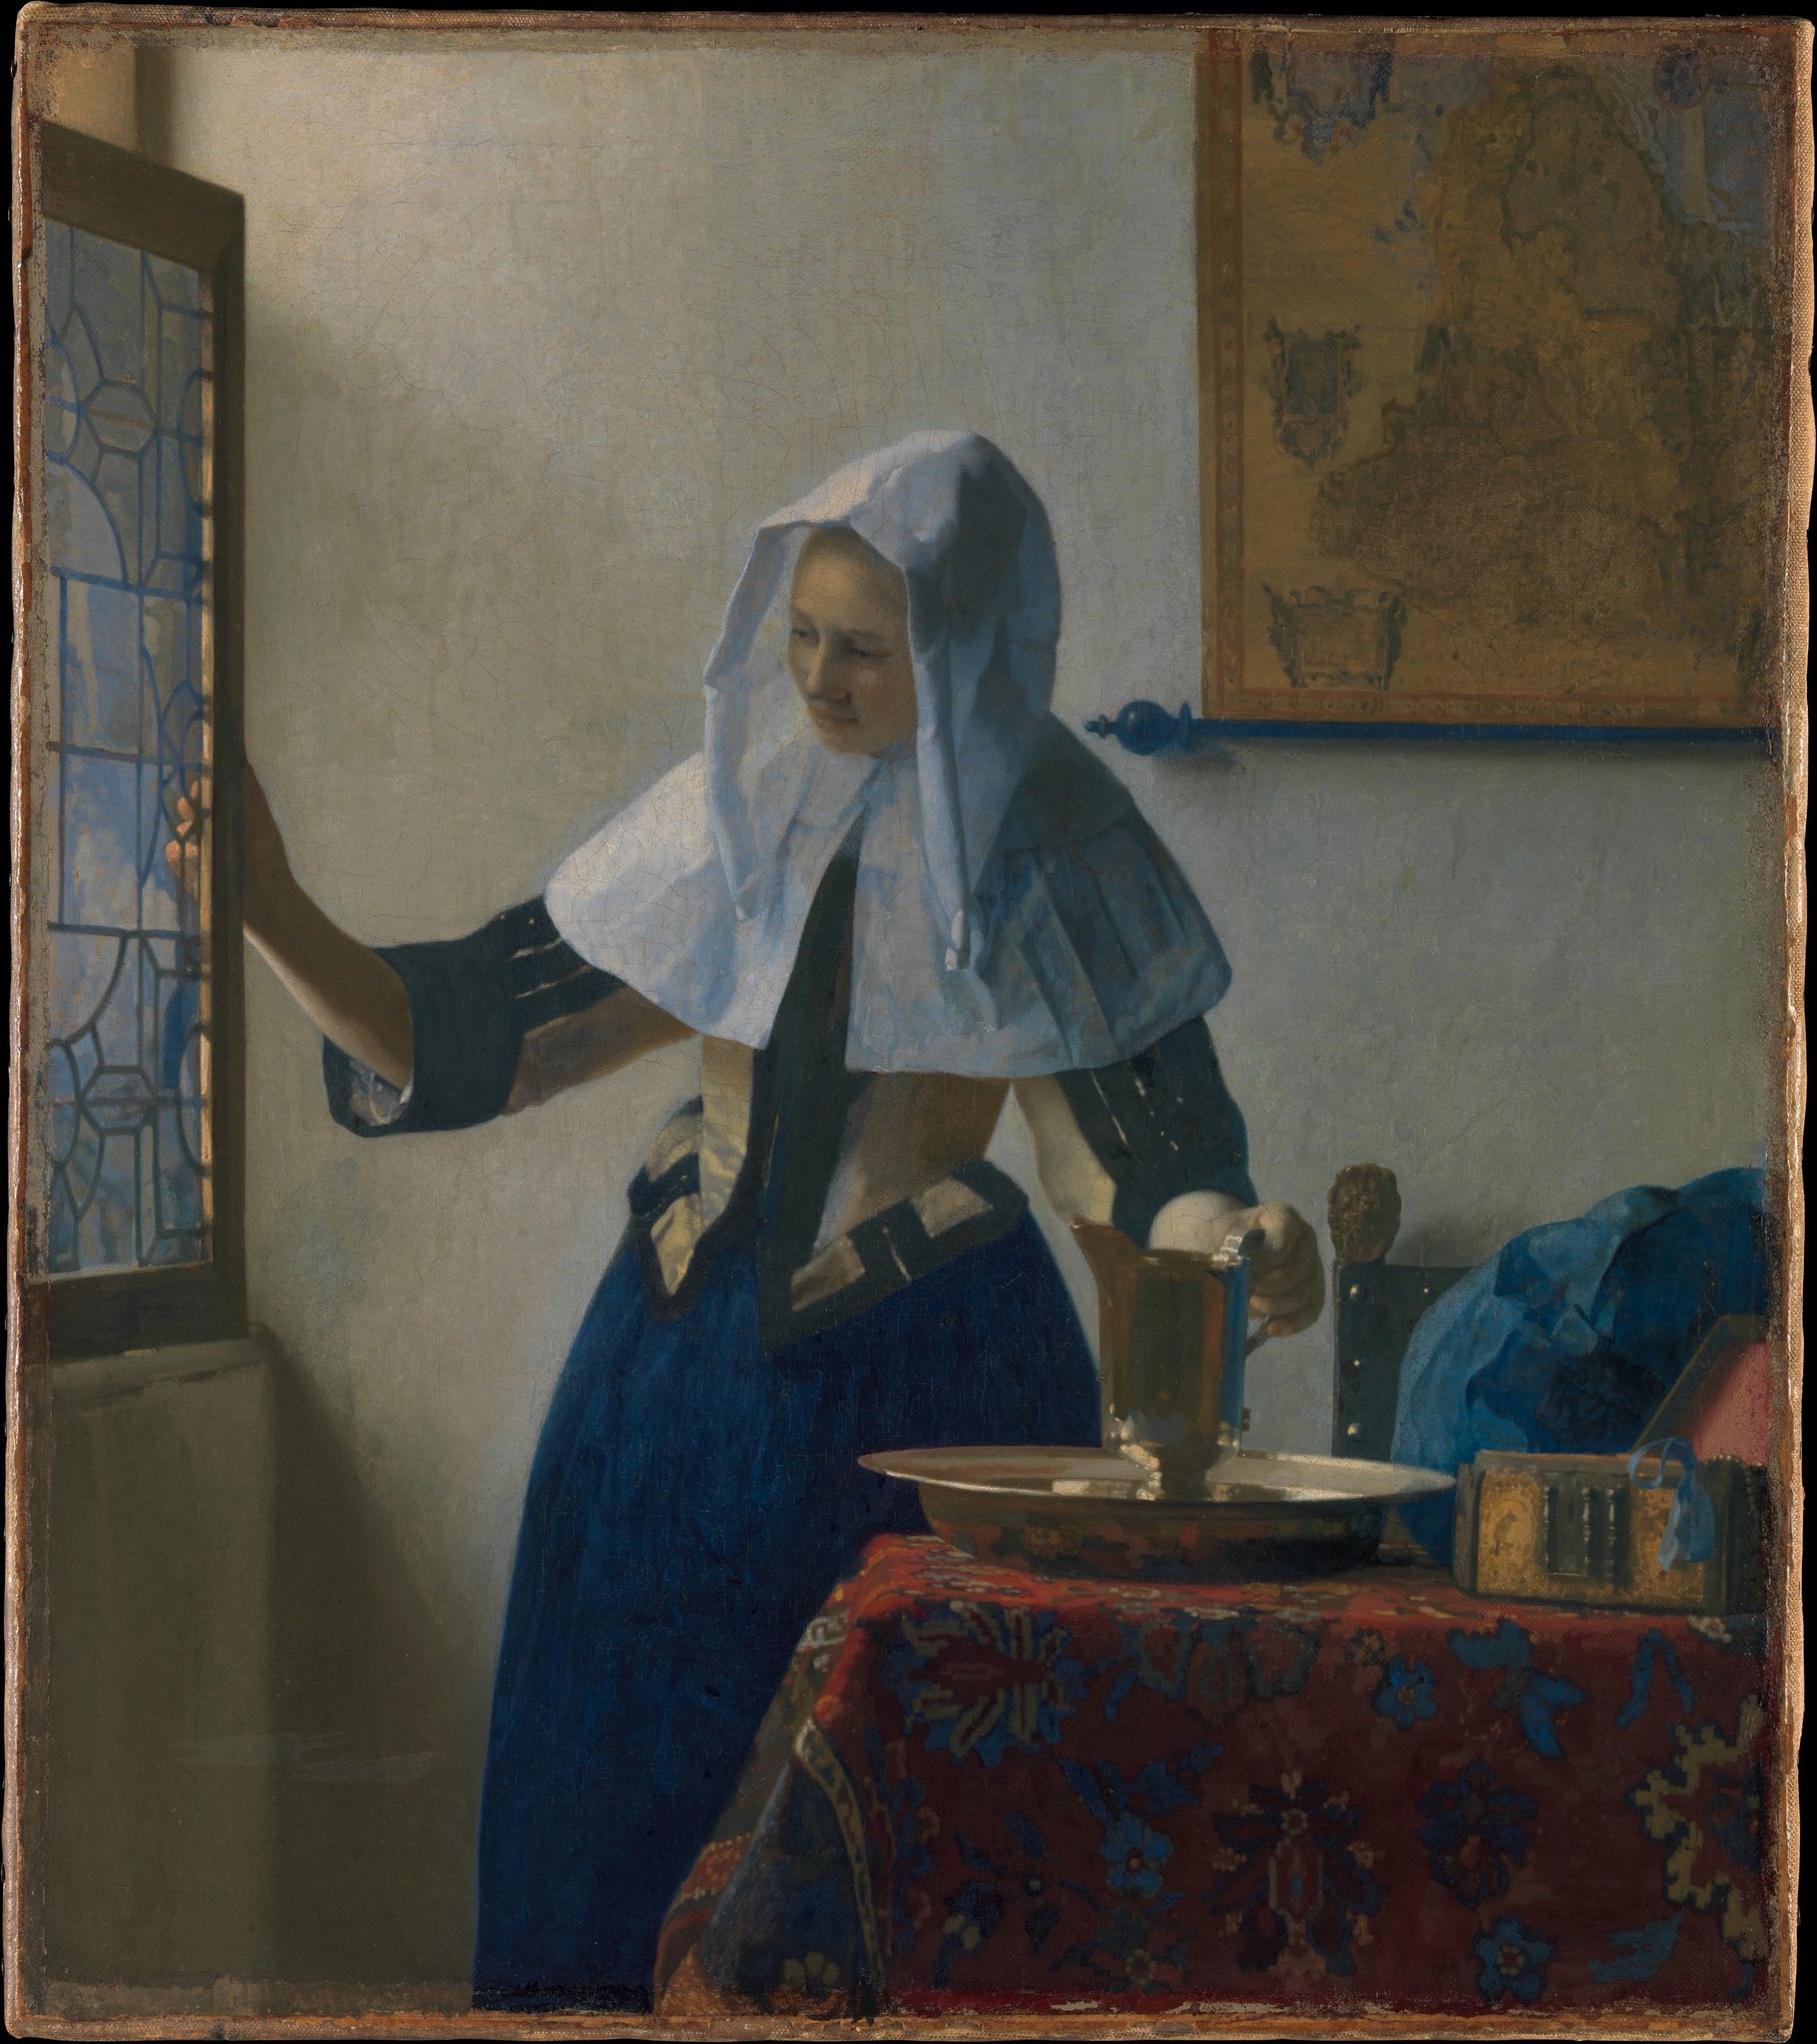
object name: painting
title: Young Woman with a Water Pitcher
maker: johannes vermeer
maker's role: artist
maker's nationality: dutch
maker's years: 1632-1675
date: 1662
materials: canvas, oil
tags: interiors,women,maps,pitchers